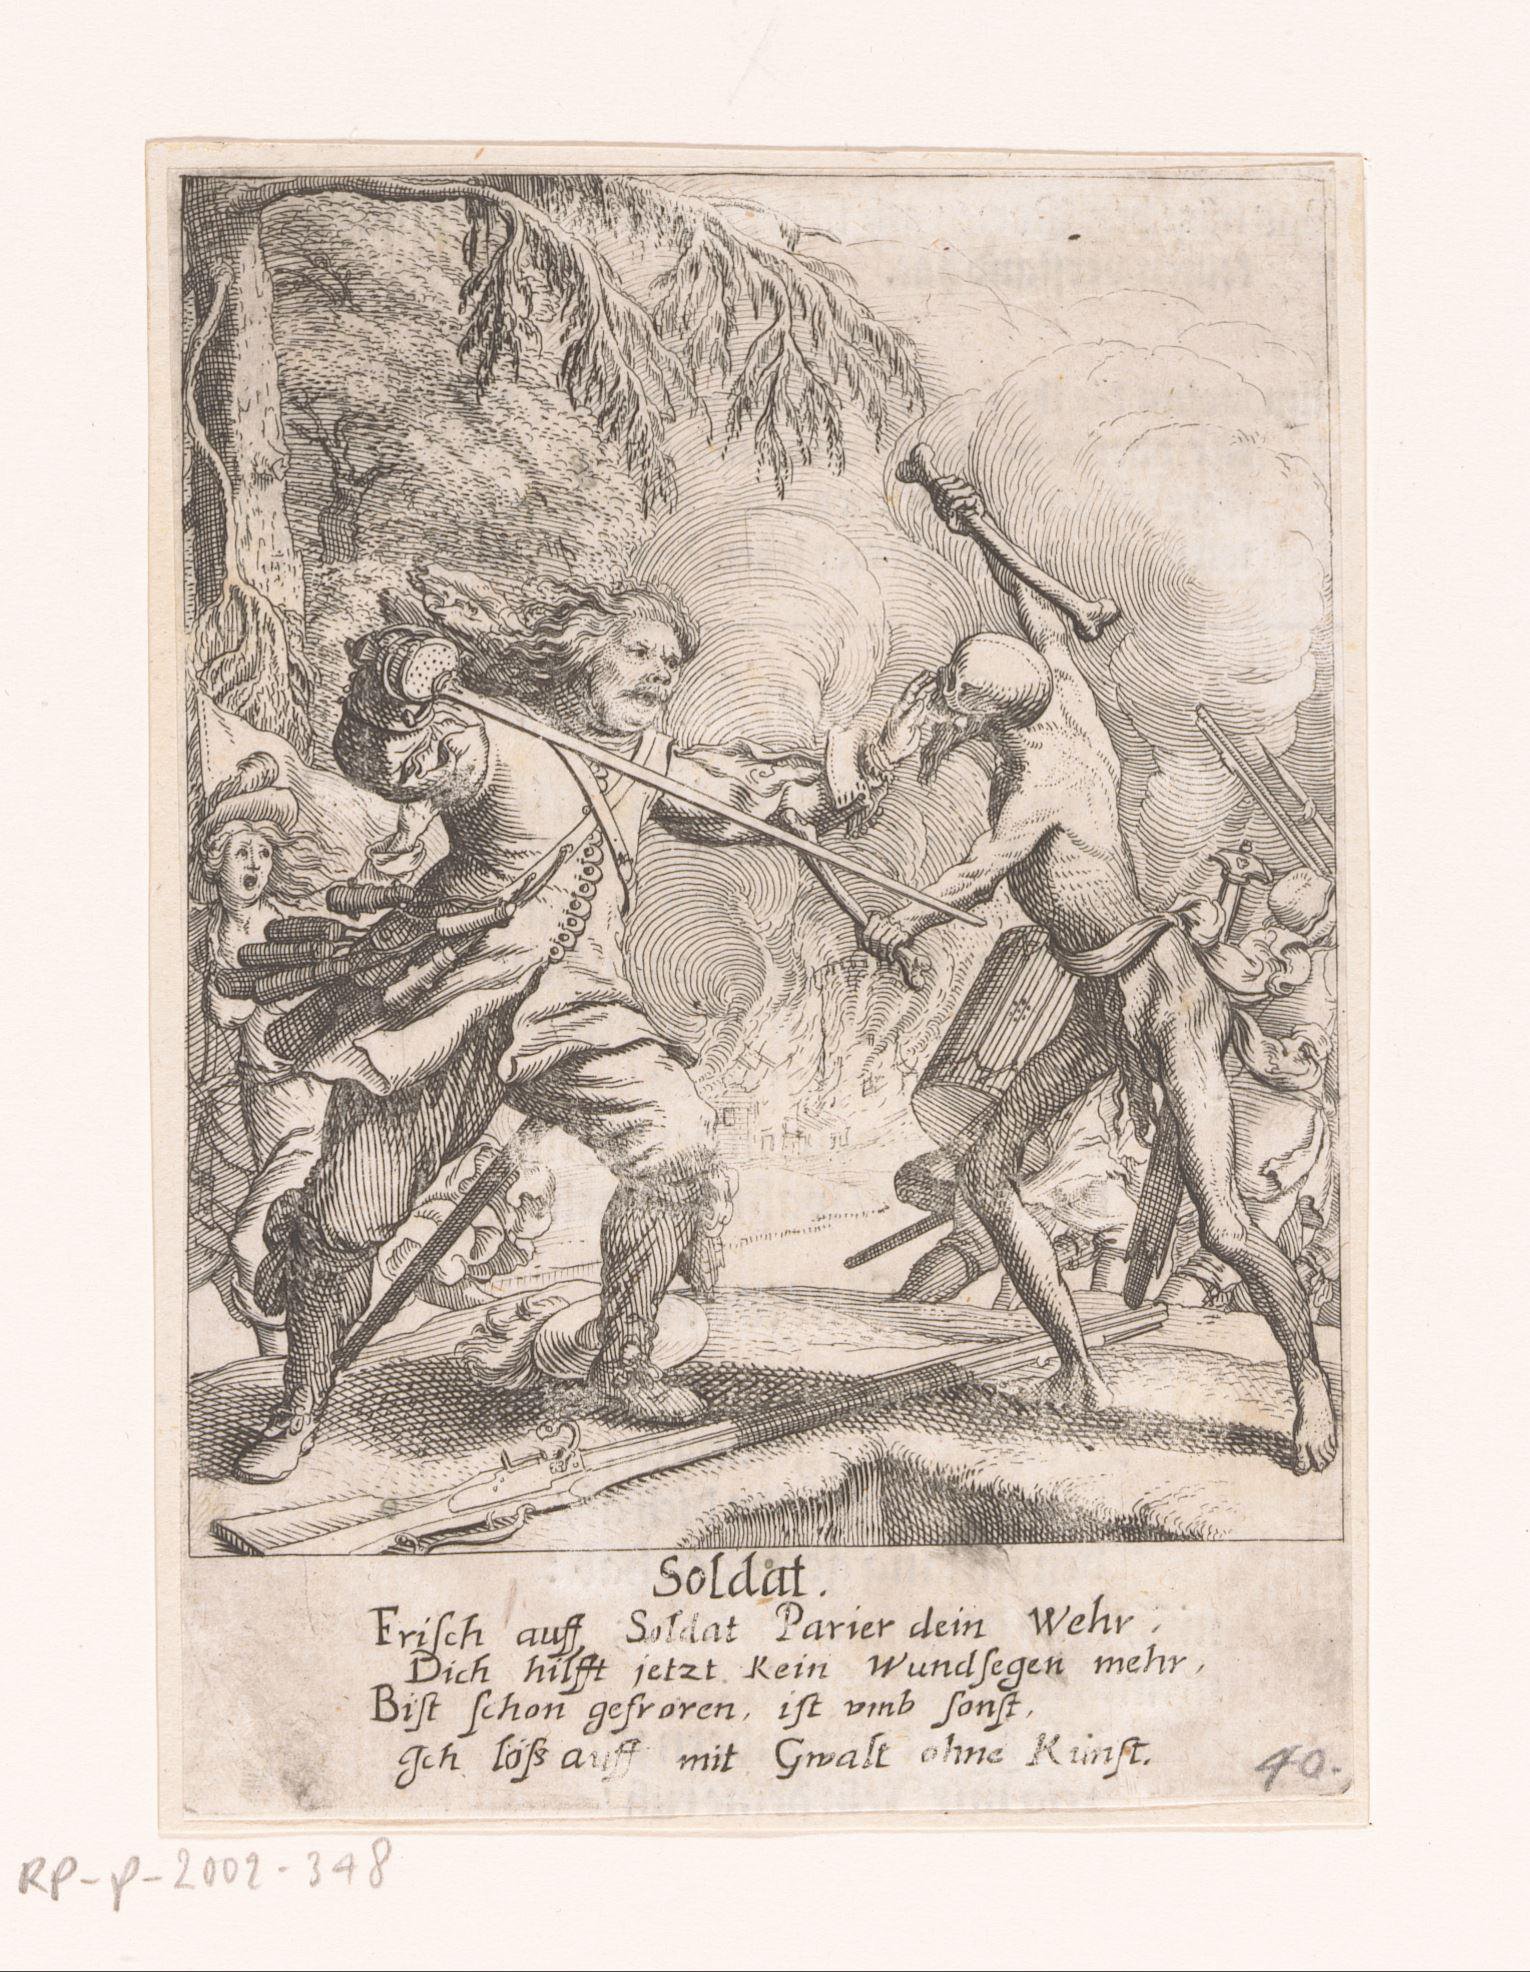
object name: print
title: De Dodendans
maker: johann jakob bodmer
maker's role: printer, publisher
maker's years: 1629-1650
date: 1650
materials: paper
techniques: etching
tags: personifications of death; 'morte' (ripa), dance of death; death together with one or more human beings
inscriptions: collector's mark: Lugt 2228, collector's mark: Lugt 2233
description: Prent uit: Meyer, Rudolph. Sterbenspiegel, das ist sonnenklare Vorstellung menschlicher Nichtigkeit durch alle Ständ und Geschlechter (...). Zürich: J.J. Bodmer, 1650.